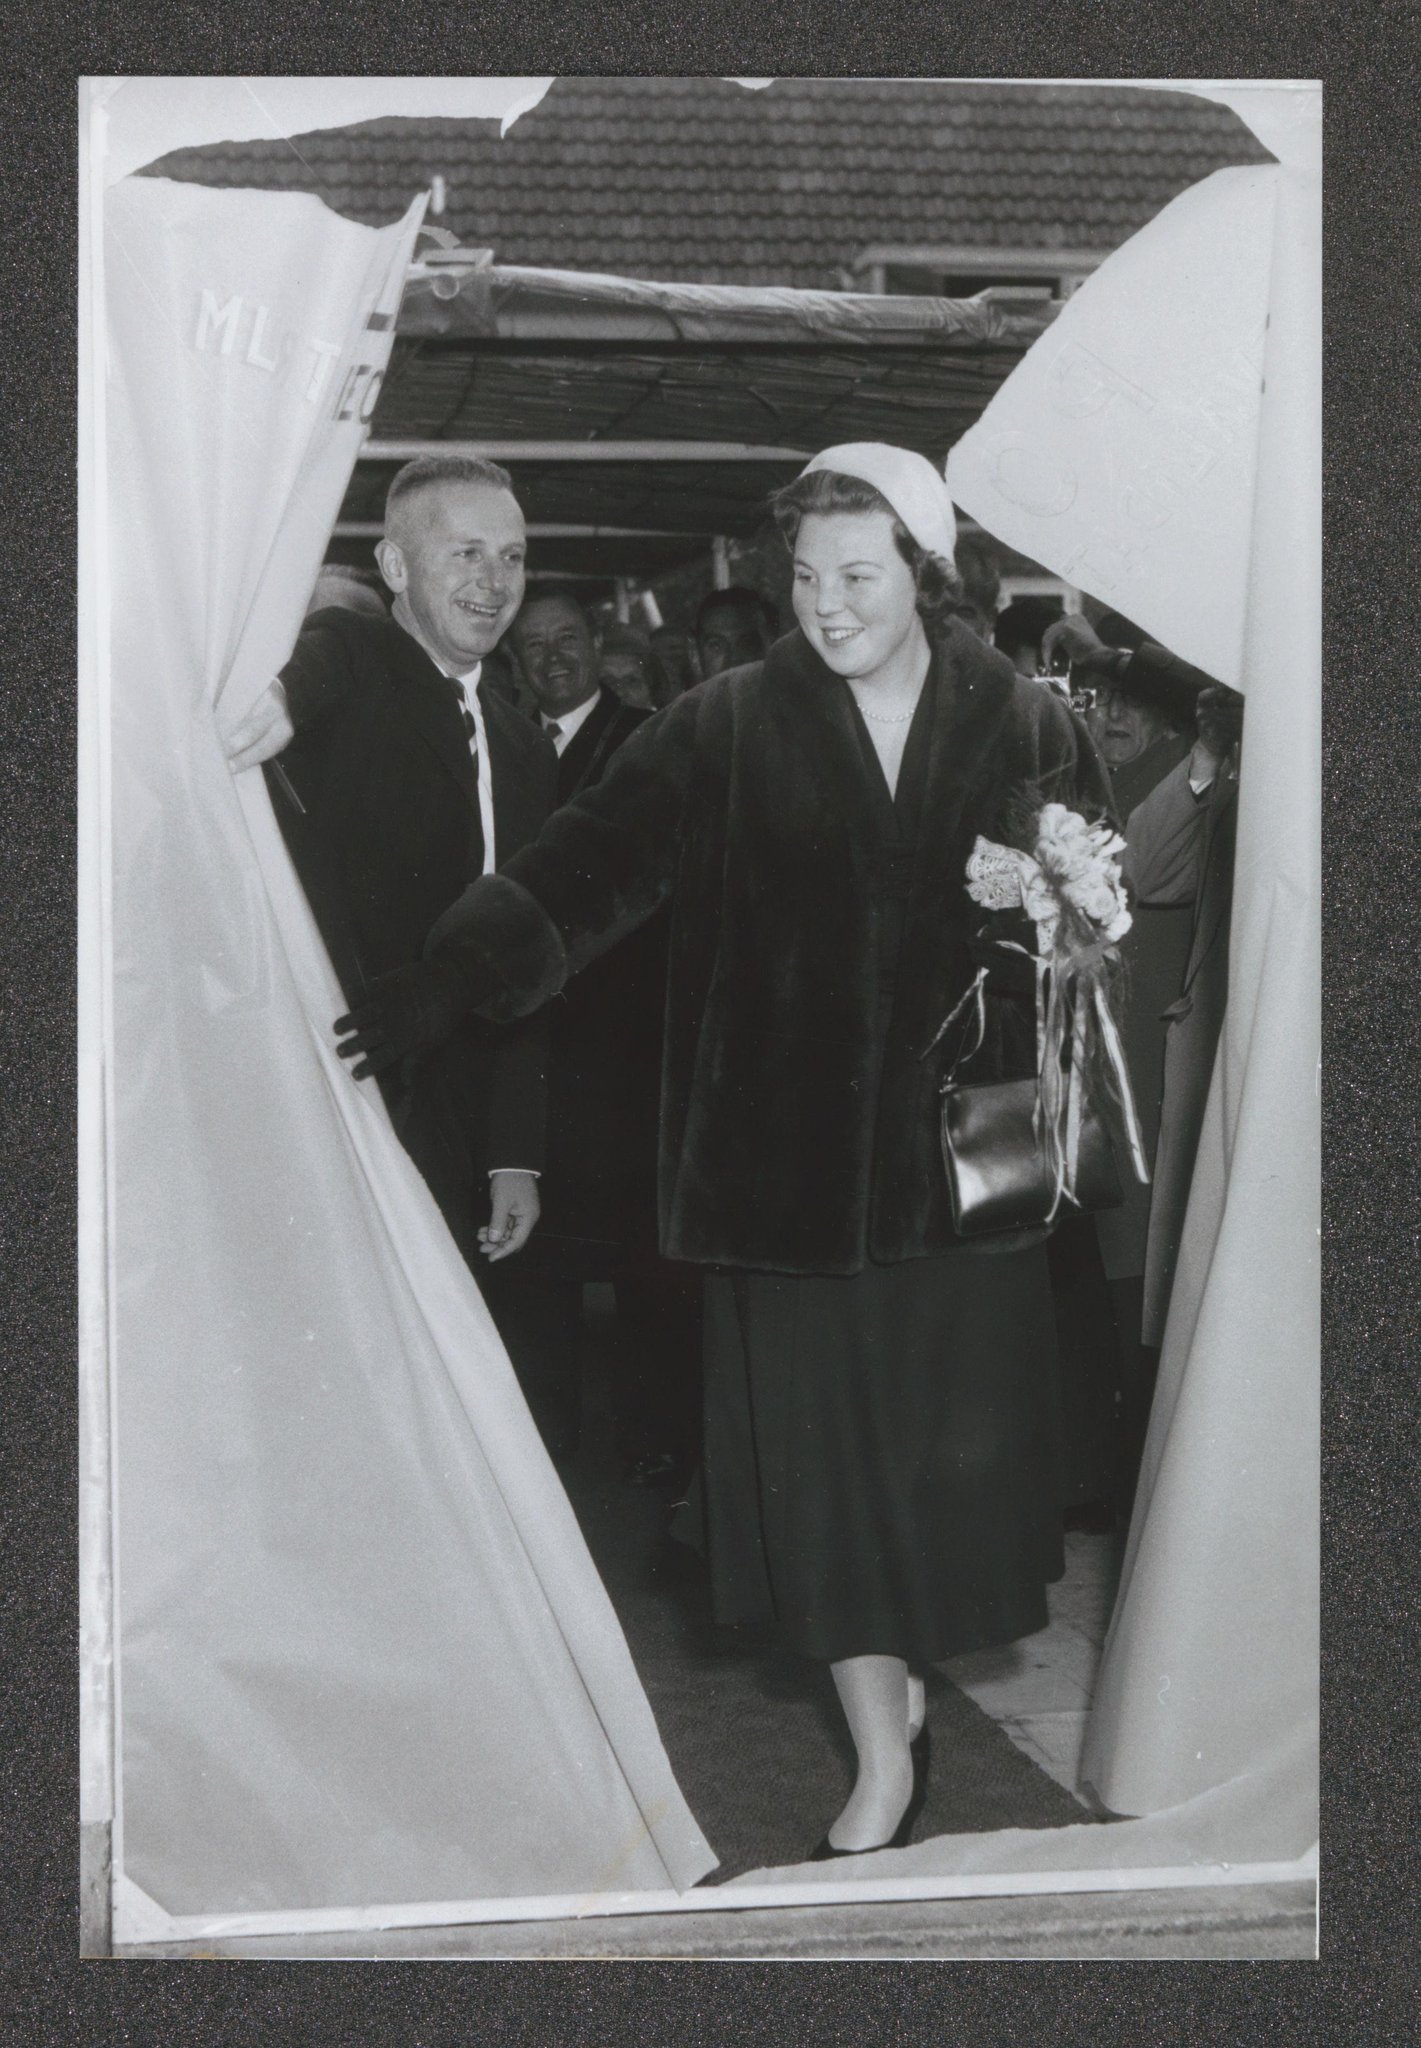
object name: photograph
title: Bezoek van Prinses Beatrix aan Suriname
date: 1958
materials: paper, photographic support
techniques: gelatin silver print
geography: netherlands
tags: beatrix (koningin der nederlanden), suriname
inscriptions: annotation: ‘Saturday 31st, 1959 H.R.H. Crown Princess Beatrix celebrates het 21st birthday and thu attains Her majority. Picture from the files: H.R.H. Pr. Beatrix in October 1957, opening a sanatorium for victims of infantile paralysis in Delft. Photo ANEFO 28-1-1959’